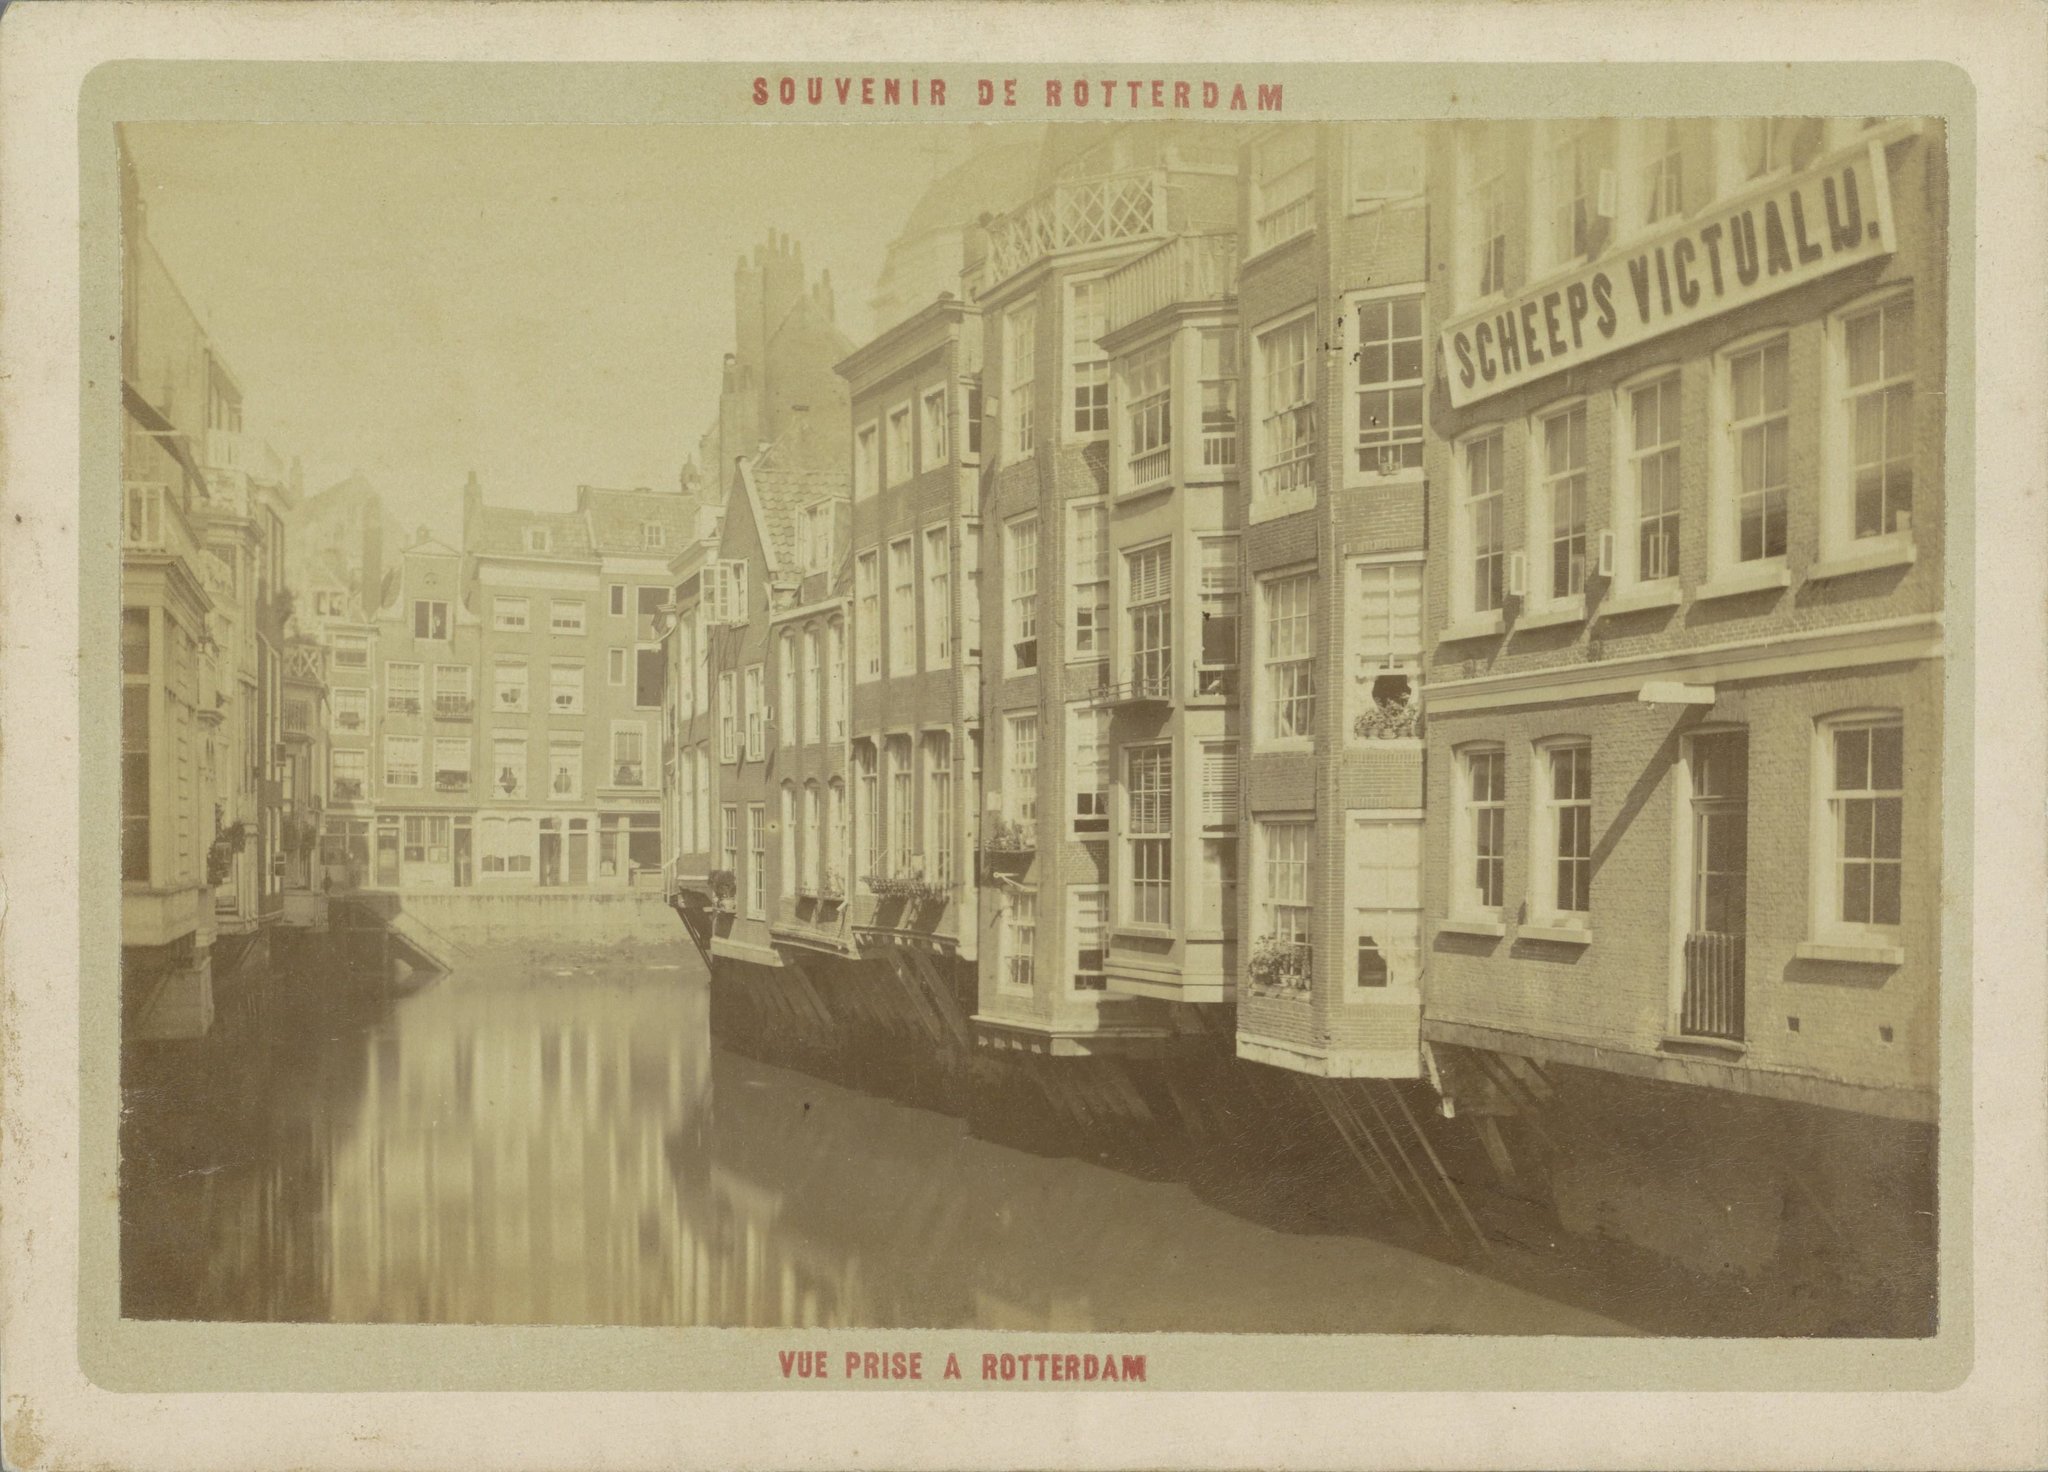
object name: cabinet photograph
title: Steigersgracht bij de Soetenbrug in Rotterdam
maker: Anonymous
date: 1860-1880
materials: cardboard, photographic support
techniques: albumen print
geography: rotterdam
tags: canal, rotterdam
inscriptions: inscription: ‘Steigersgracht bij de Soetenbrug.’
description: Onderdeel van Verzamelband met foto's van Rotterdam.